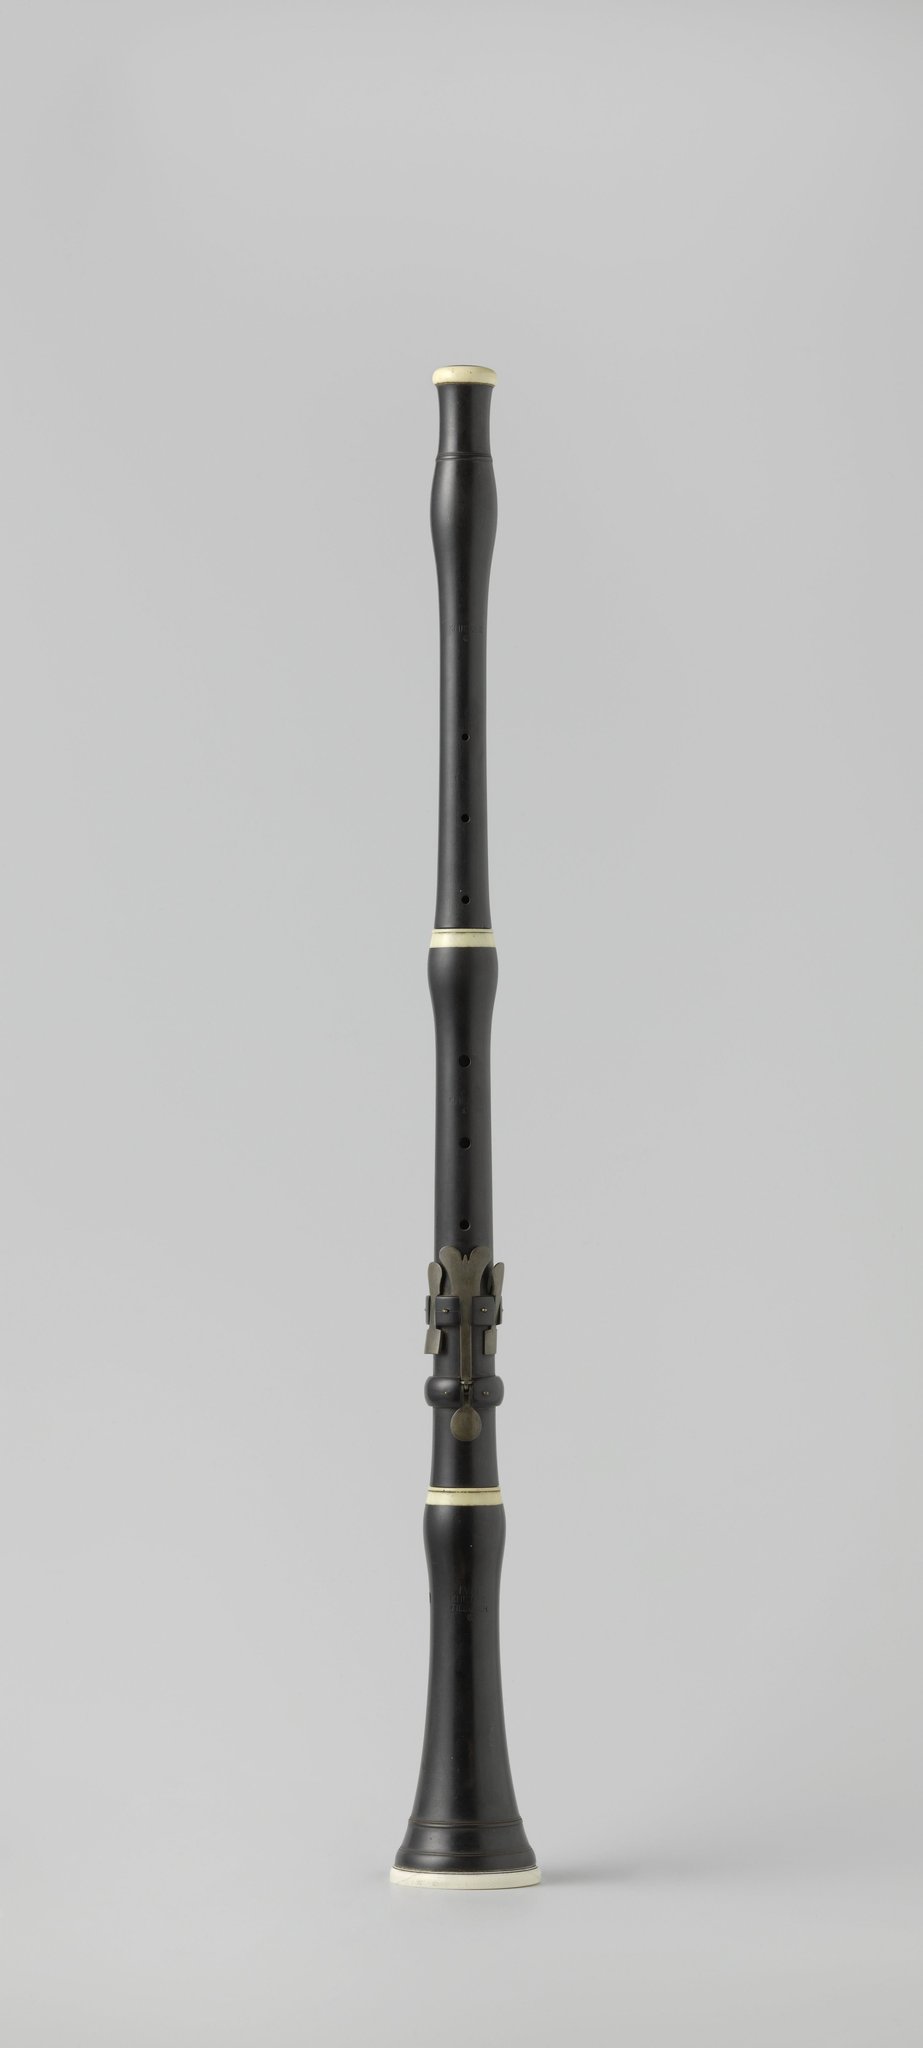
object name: wind instrument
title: Oboe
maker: johannes van de knikker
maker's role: musical instrument maker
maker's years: 1731-1815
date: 1780-1800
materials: wood, ivory, silver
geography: tilburg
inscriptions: mark, on the bell, stamped: ‘I.V.D/ KNIKKER/ TILBORGH’ I.V.D/ KNIKKER/ TILBORGH/ [a star], mark, above tone hole 1 and between holes 4 and 5, stamped: ‘KNIKKER’ KNIKKER/ [a star]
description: Hobo ebbenhout met ivoren randen en drie zilveren kleppen.